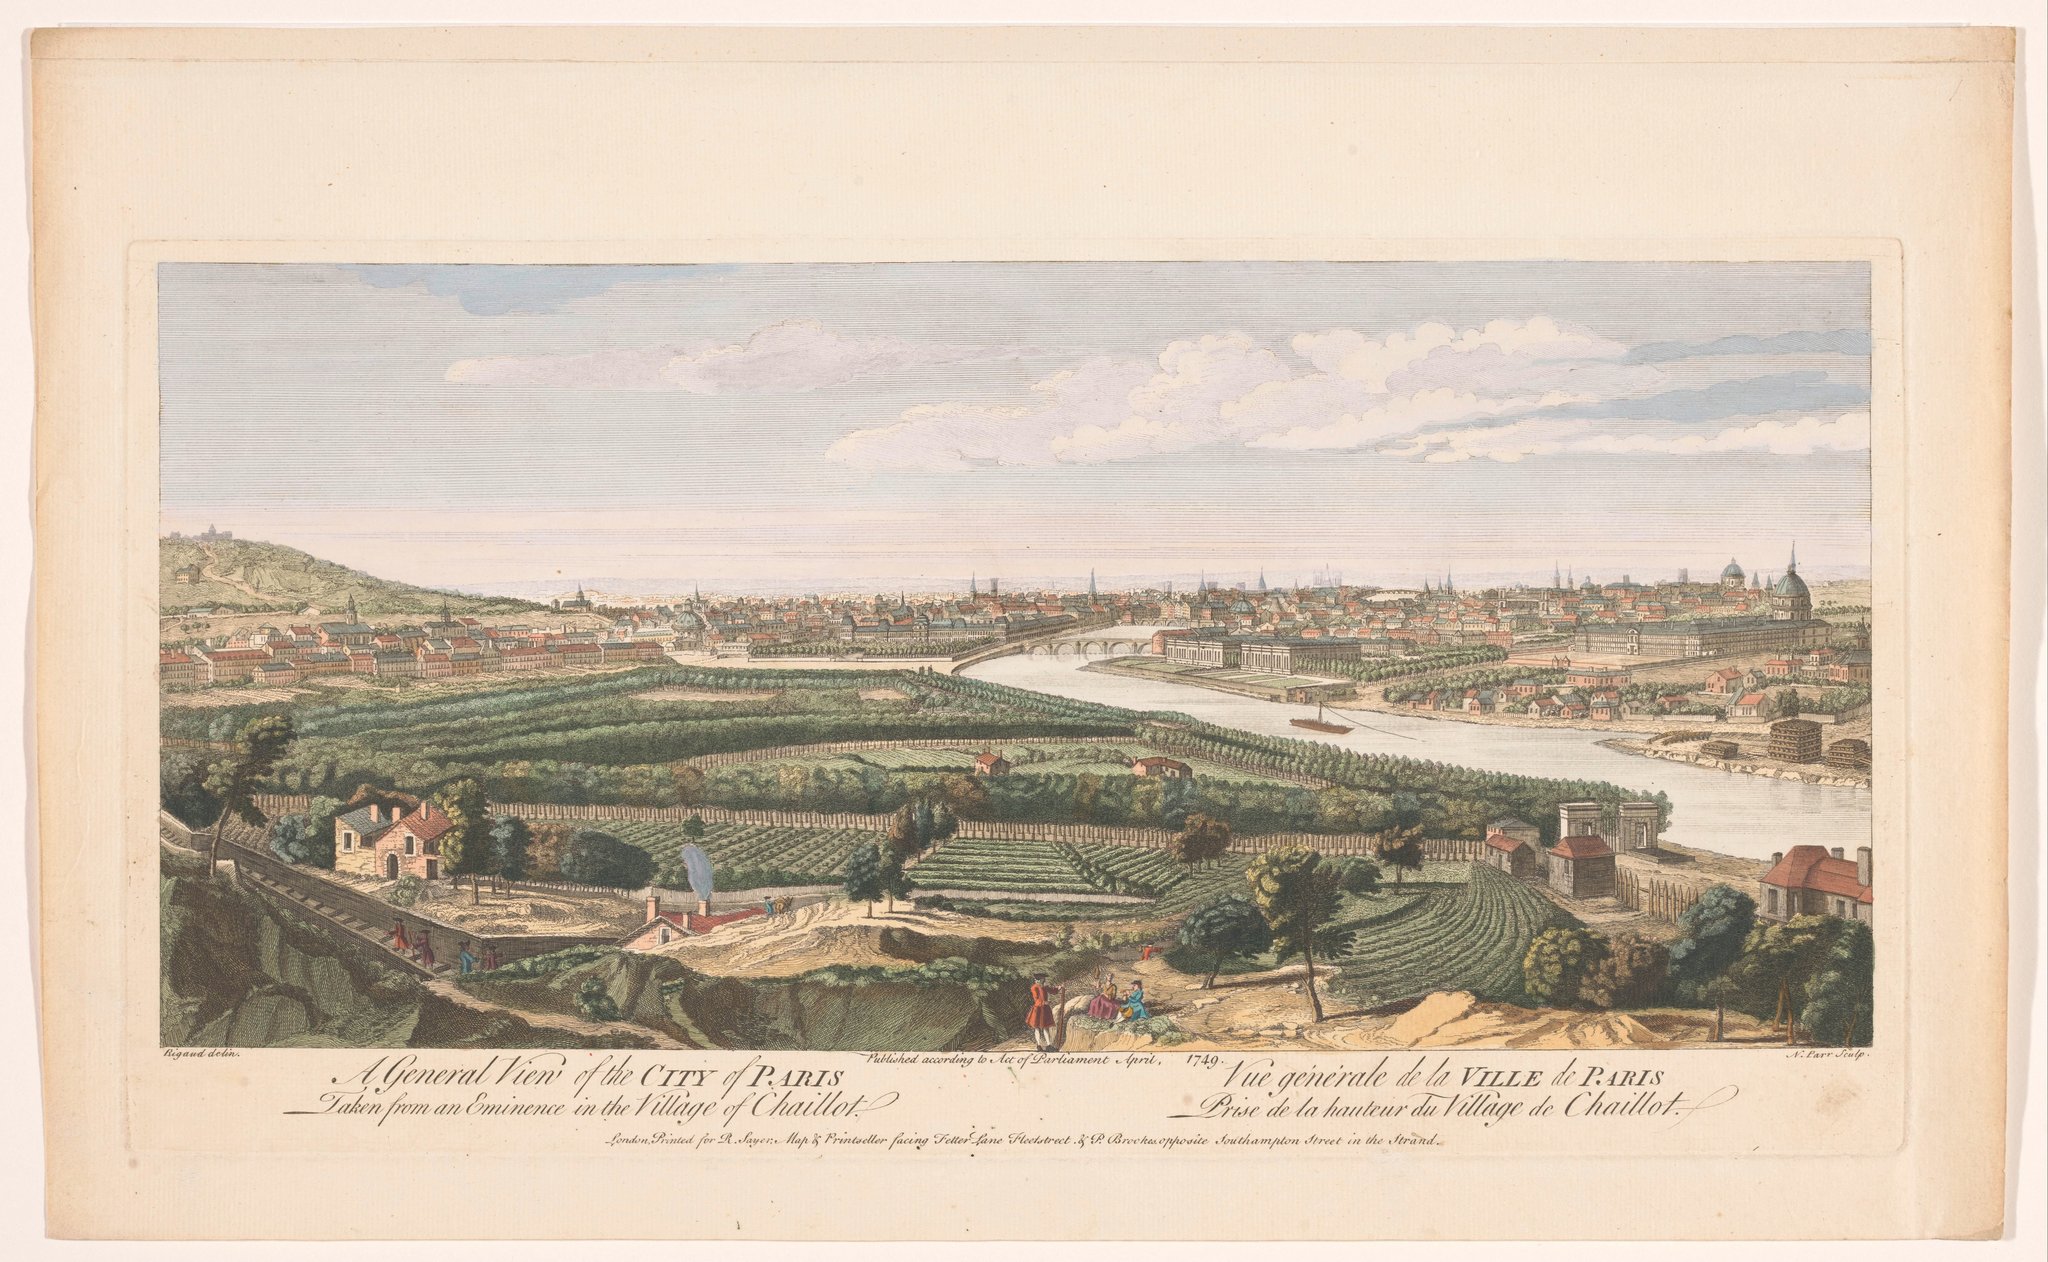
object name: print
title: Gezicht op de stad Parijs gezien vanaf het dorp Chaillot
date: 1704-1749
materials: paper, watercolor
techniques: brush, etching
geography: london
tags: city-view in general; 'veduta', paris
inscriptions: watermark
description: De serie “Parijs” bevat zes prenten met de nummers 1-6, waarvan dit nummer 1 is.